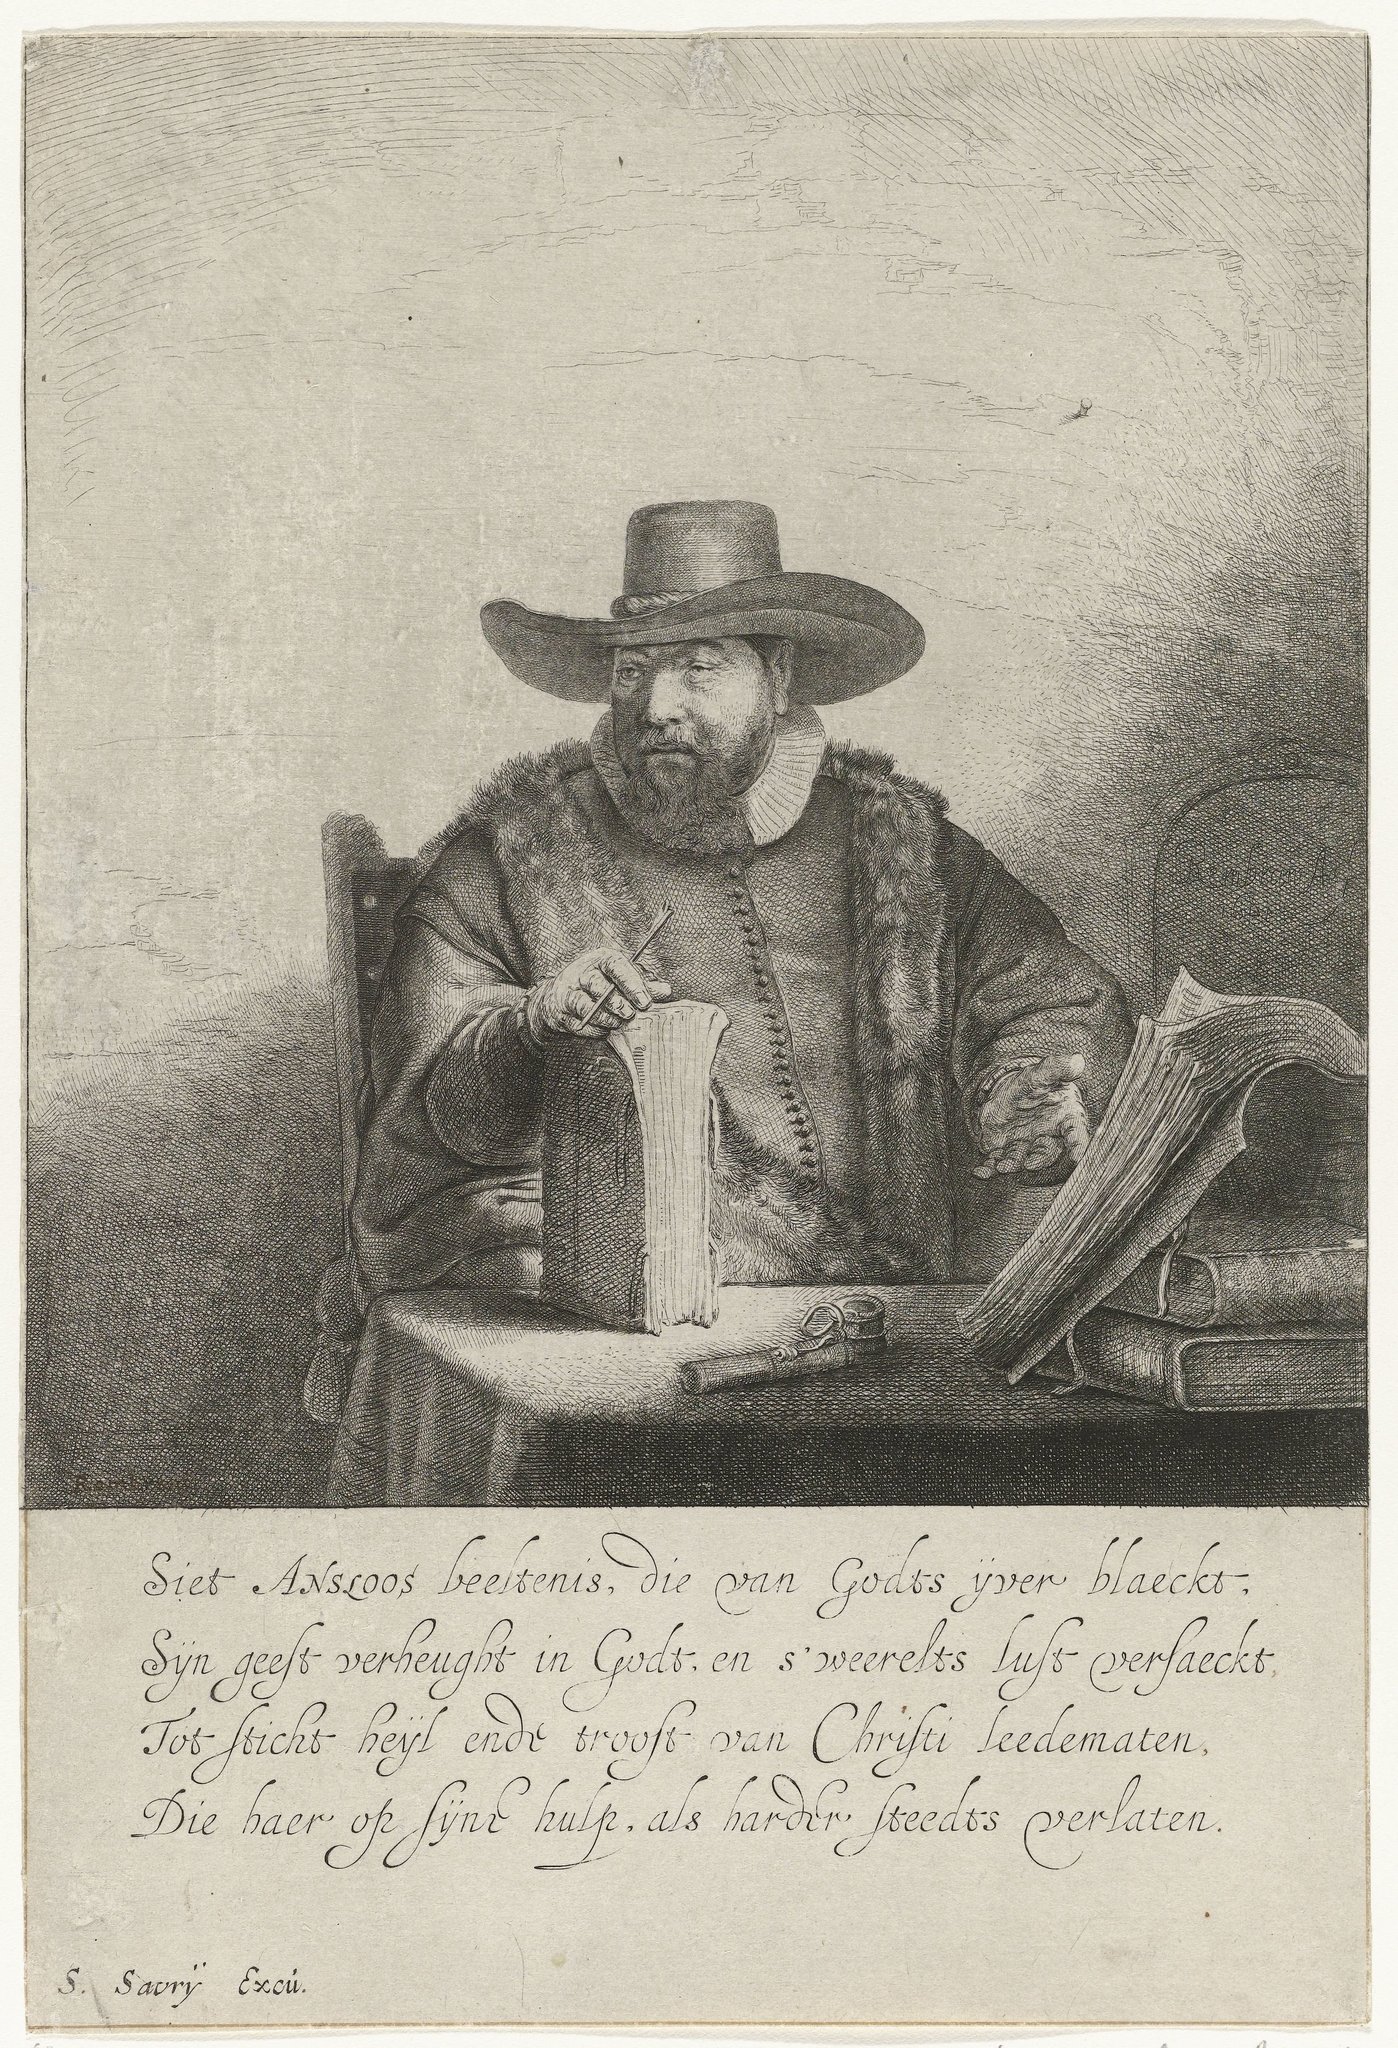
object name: print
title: Portret van de doopsgezinde predikant Cornelis Claesz. Anslo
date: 1641-1665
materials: paper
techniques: engraving, etching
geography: amsterdam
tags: predikant, koopman, cornelis claesz. anslo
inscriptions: collector's mark: Lugt 2228